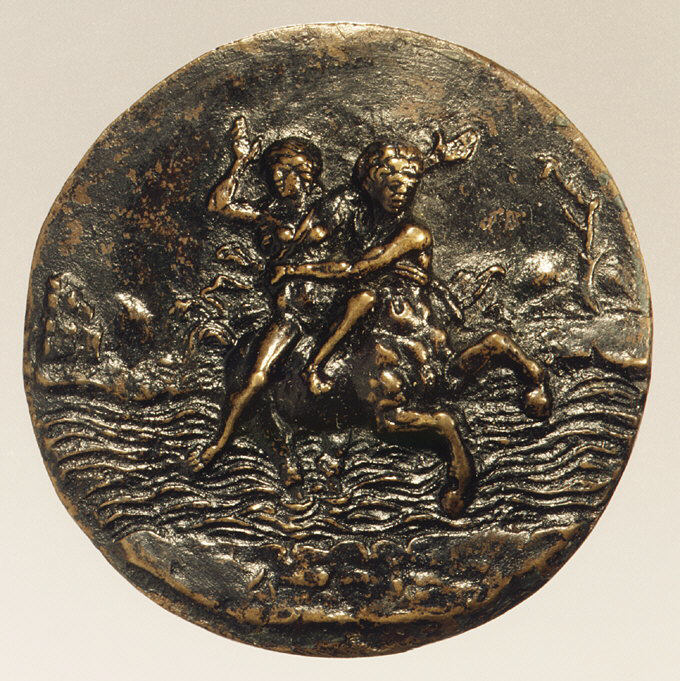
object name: plaquette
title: Nessus Abducting Dejanira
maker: andrea briosco, called riccio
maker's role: artist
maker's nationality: italian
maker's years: 1470-1532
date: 1501-1600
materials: bronze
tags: women,centaurs